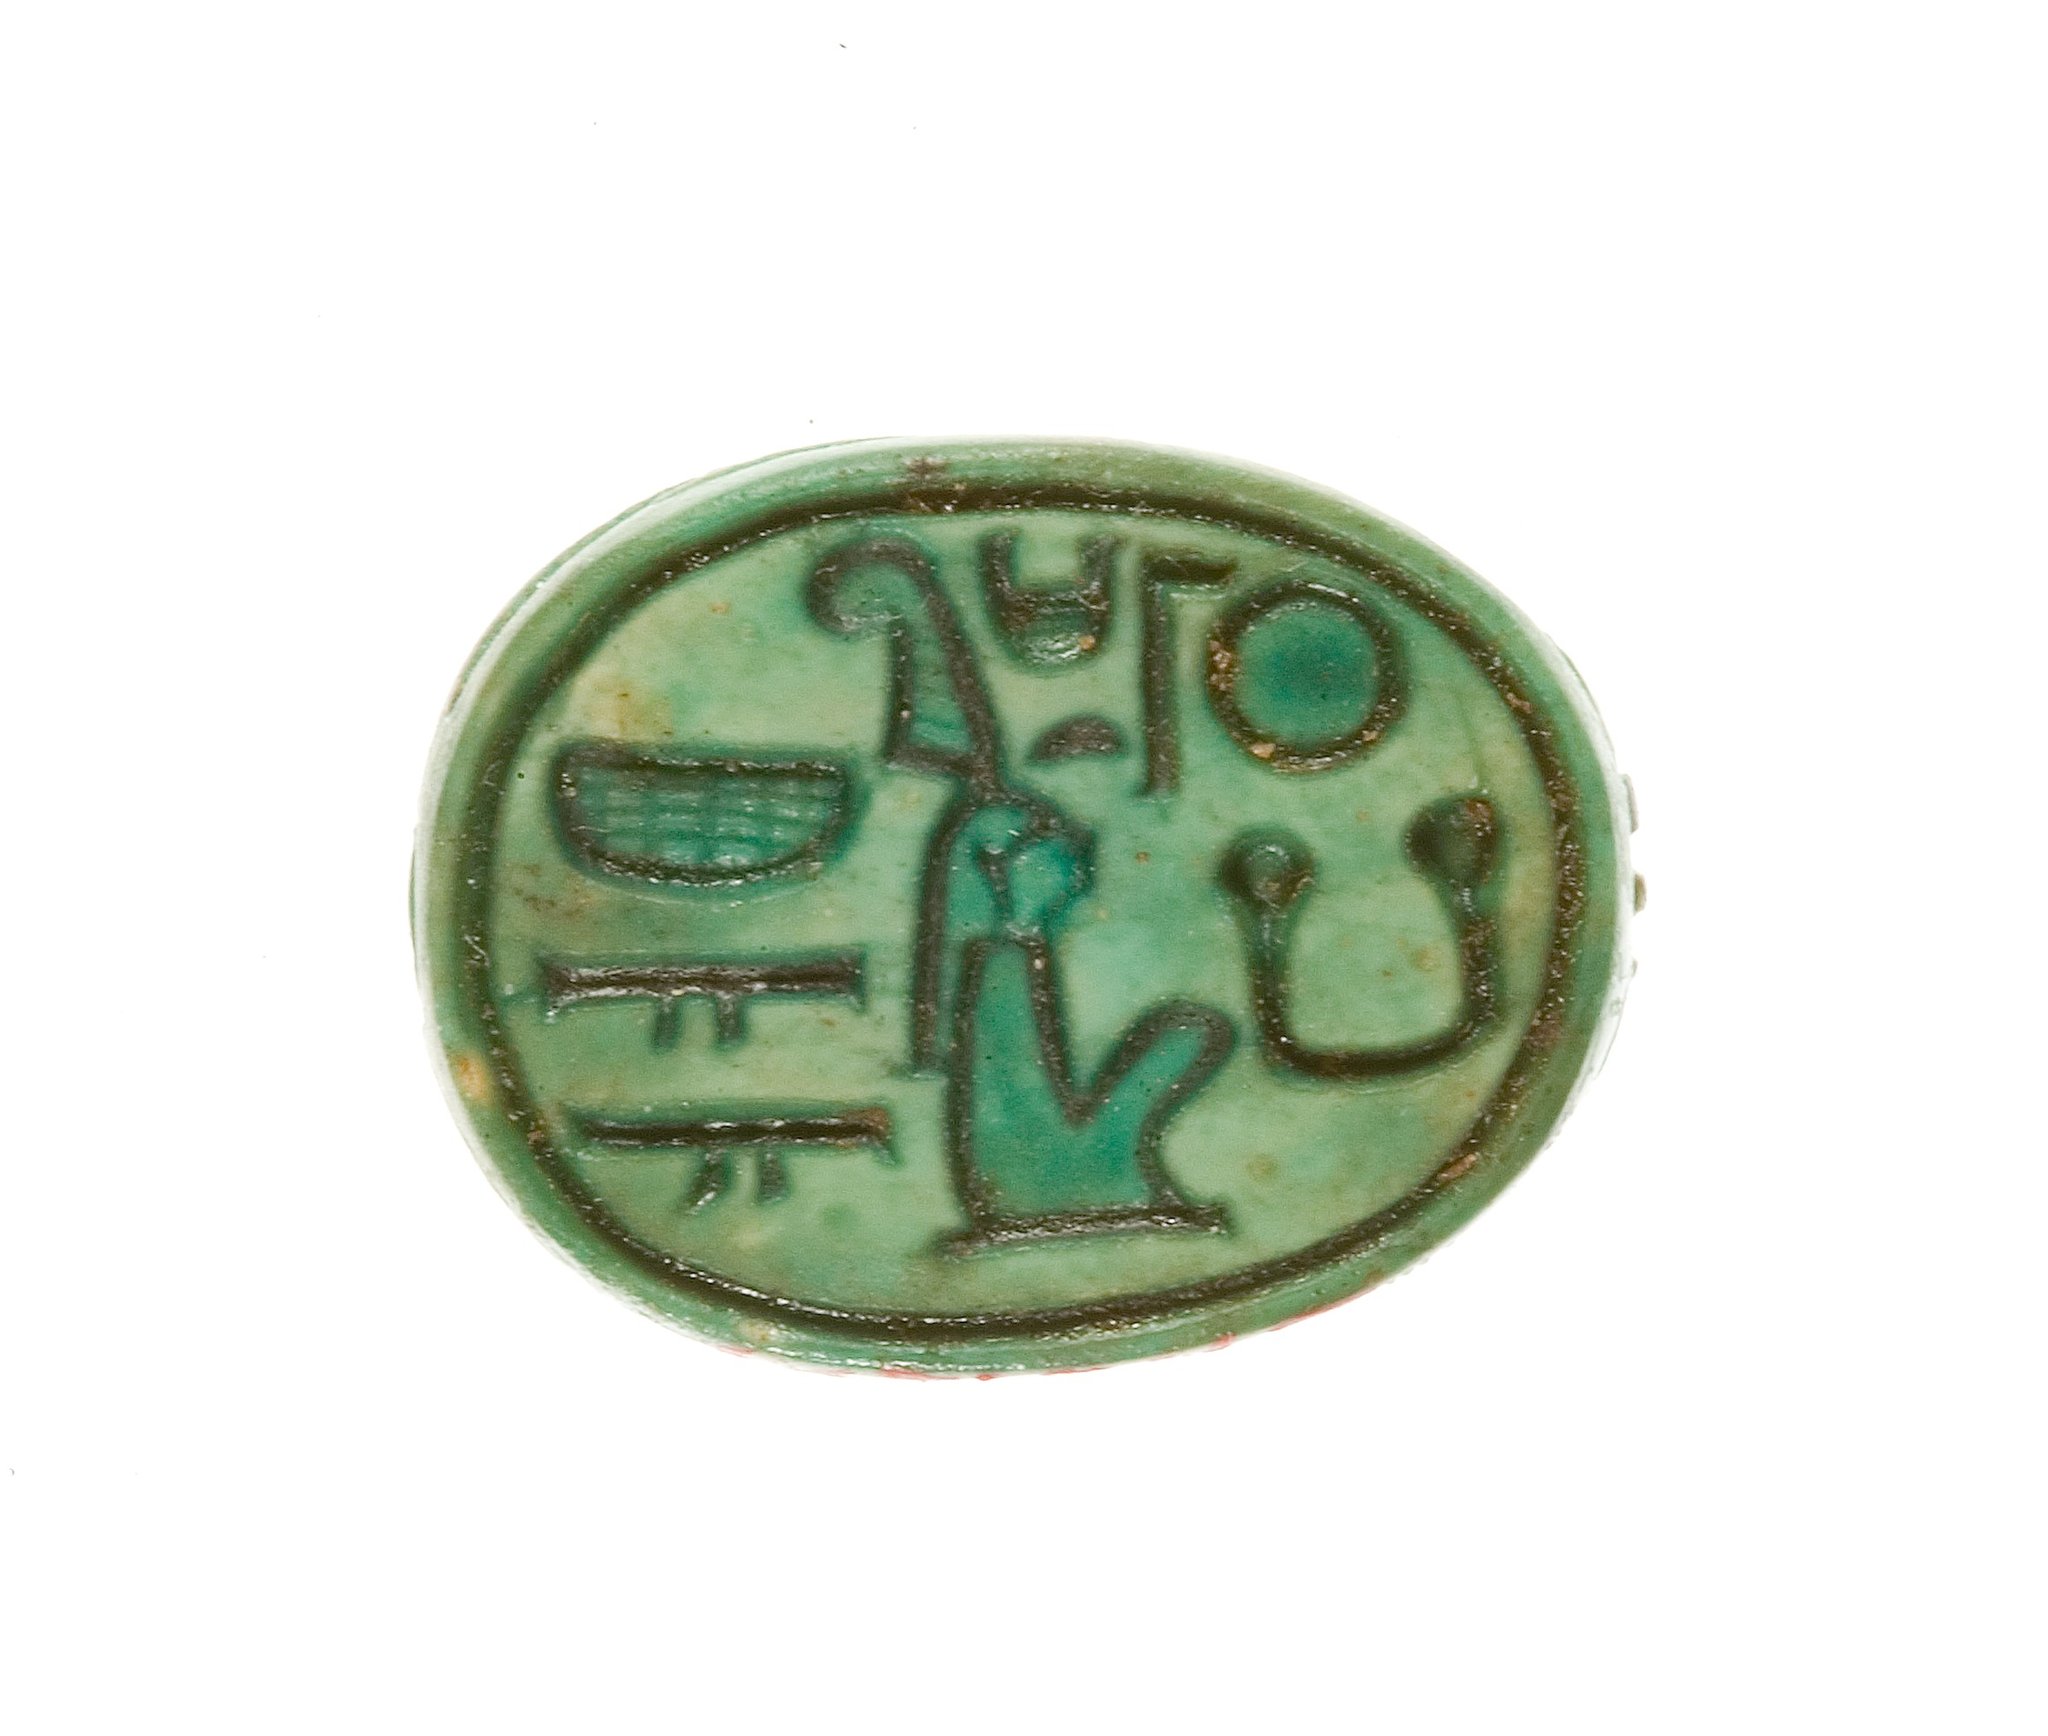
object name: scarab, hatshepsut, maatkare, god's wife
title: Scarab Inscribed "God's Wife Maatkare, Lady of the Two Lands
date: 1479-1458 BCE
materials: stone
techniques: glazing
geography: egypt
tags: hieroglyphs,scarabs